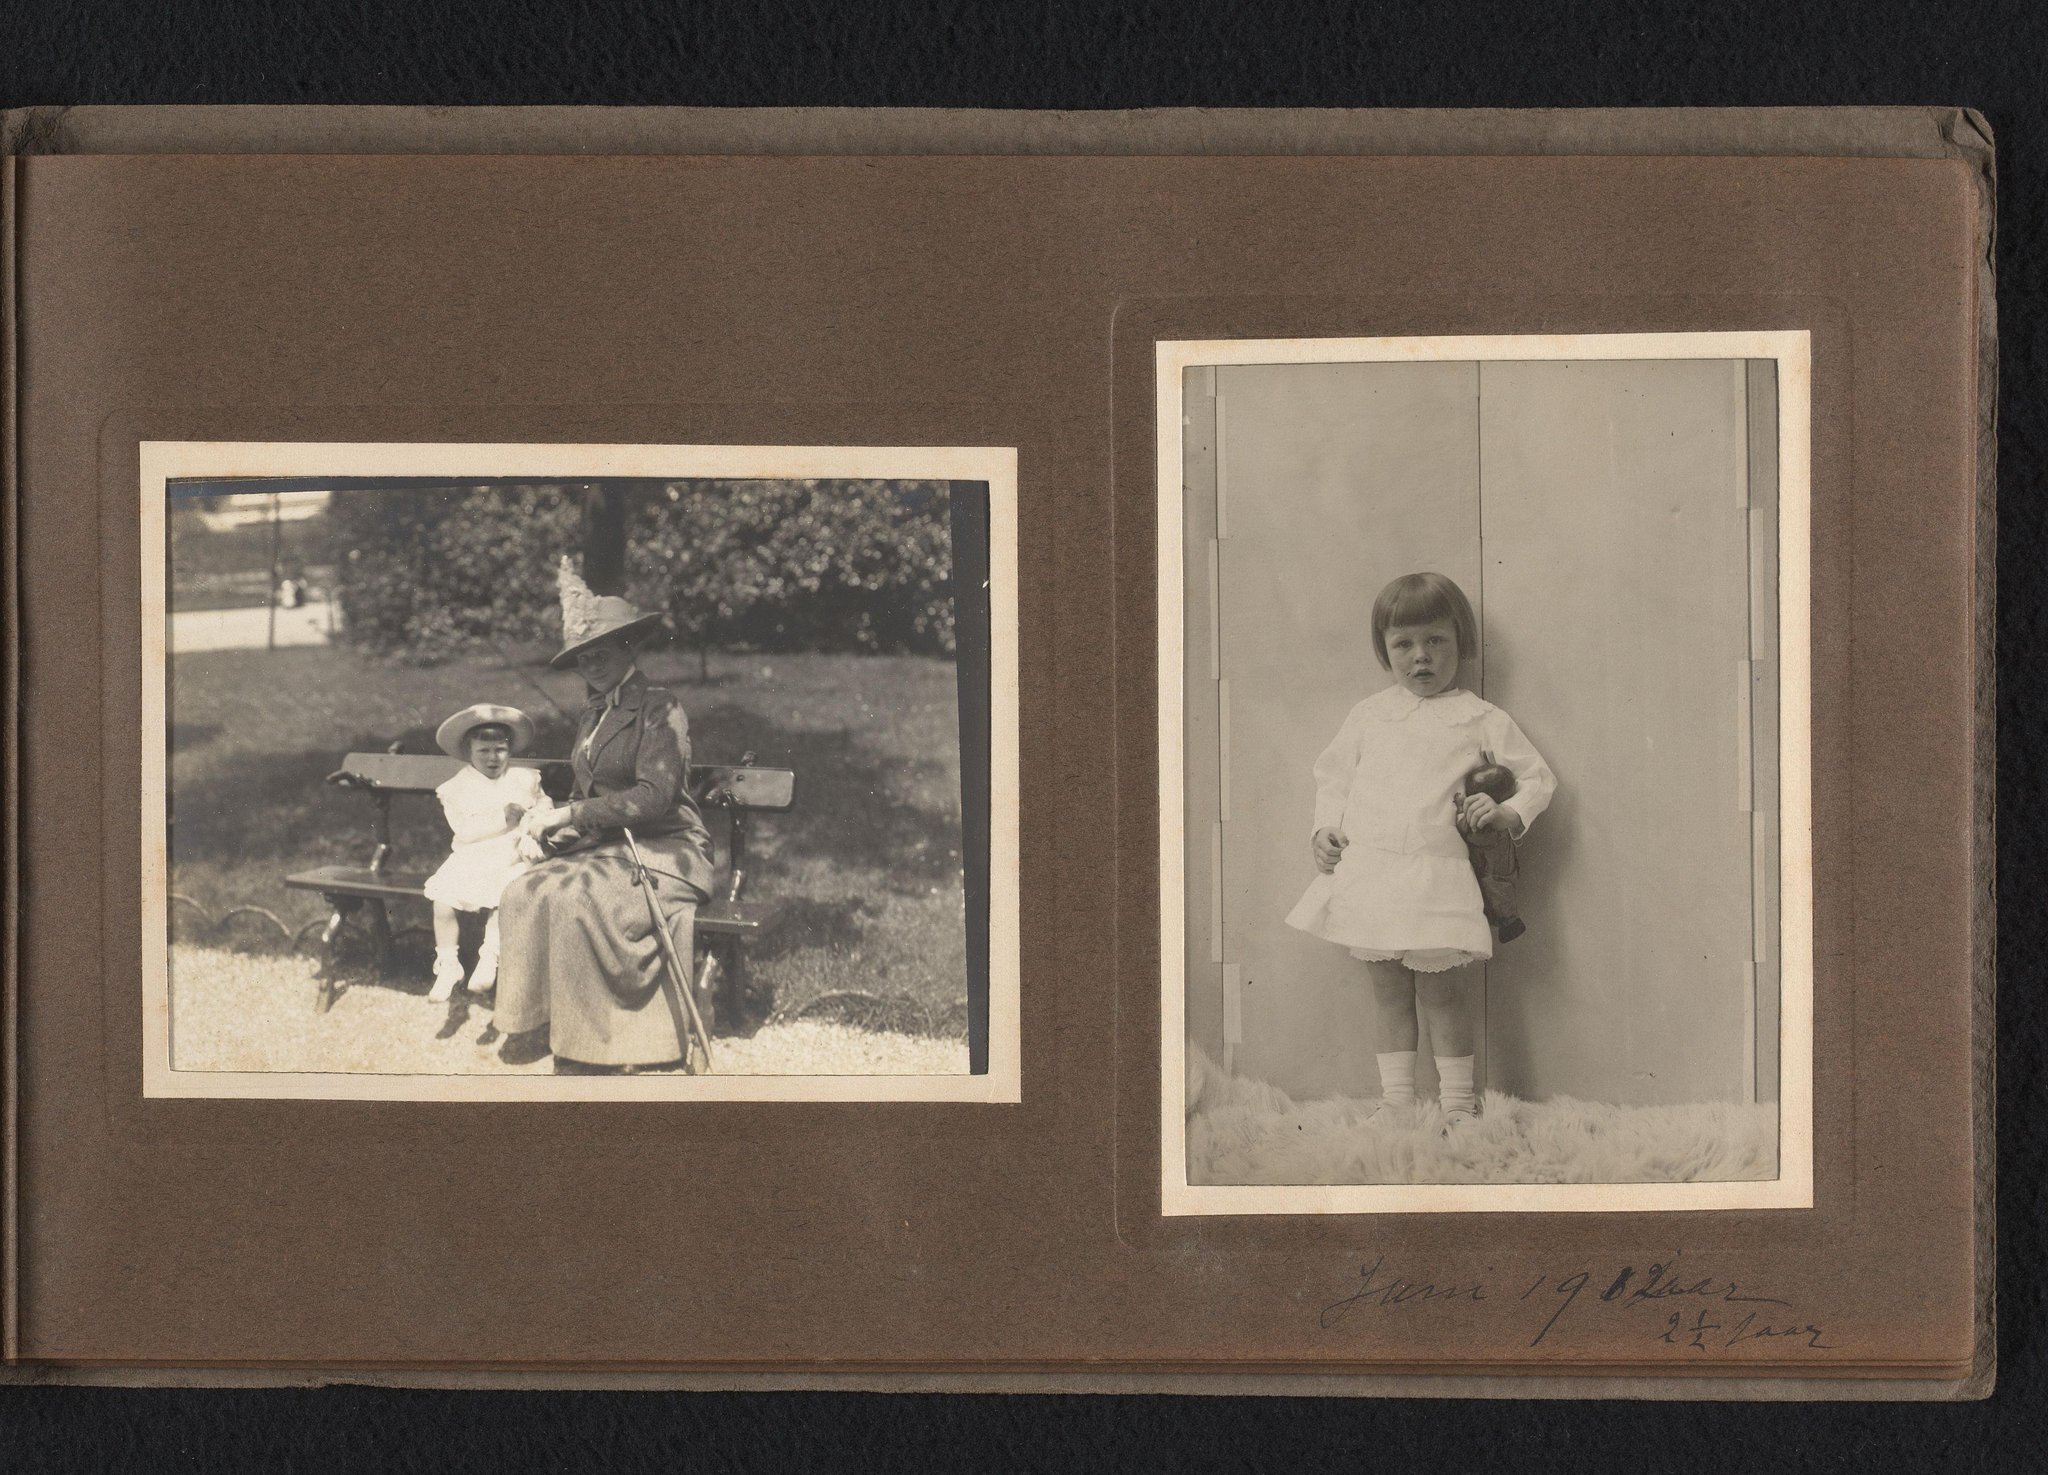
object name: album leaf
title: Caroline van den Berg met haar zoon Carel in Artis, rechts een portret van Carel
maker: hendrik herman van den berg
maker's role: amateurfotograaf, jurist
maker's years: 1875-1944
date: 1906-1912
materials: paper, cardboard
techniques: gelatin silver print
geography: artis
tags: the hague, caroline louise van den berg-van den berg, amsterdam, carel frederik van den berg (cay), historical persons, zoo (as place of recreation)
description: Deze foto's zijn onderdeel van een album.